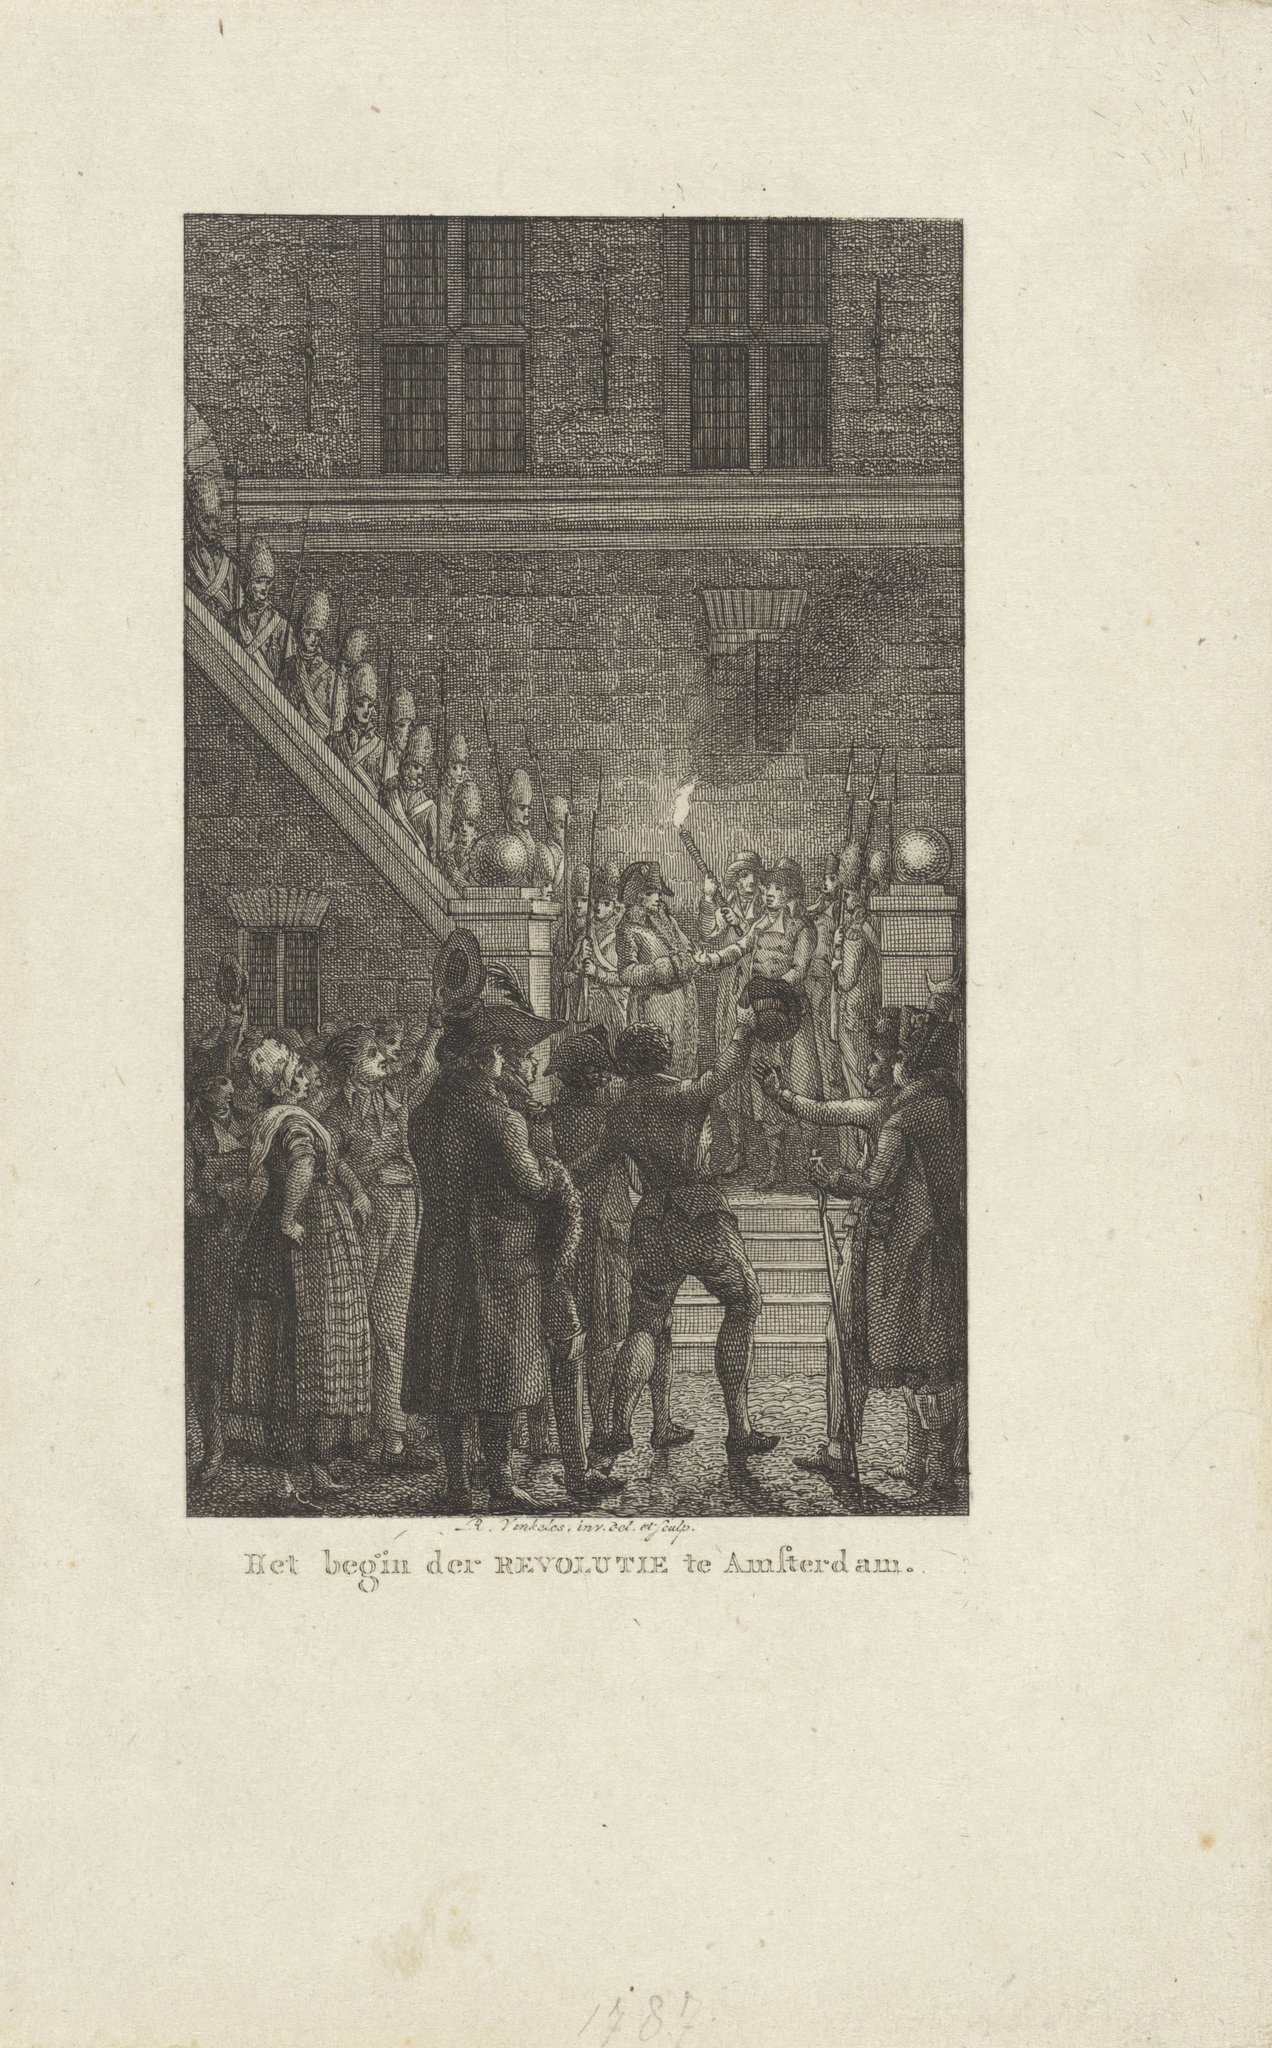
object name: history print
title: Het begin der Revolutie te Amsterdam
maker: reinier vinkeles (i)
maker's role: draughtsman, print maker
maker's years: 1741-1816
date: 1800-1802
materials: paper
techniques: engraving, etching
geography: amsterdam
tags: nijmegen, physicist, cornelis rudolphus theodorus krayenhoff, pierre jean baptiste charles van der aa, torch, proclamation of new government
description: Het begin van de revolutie in Amsterdam, 19 januari 1795. Secretaris P.J.B.C. van der Aa kondigt bij toortslicht staande op de trap van de Waag op de Dam te Amsterdam de overgave van het bewind van de burgemeesters aan het Comité-Revolutionair aan en benoemt C.R.Th. Krayenhoff tot militair commandant.